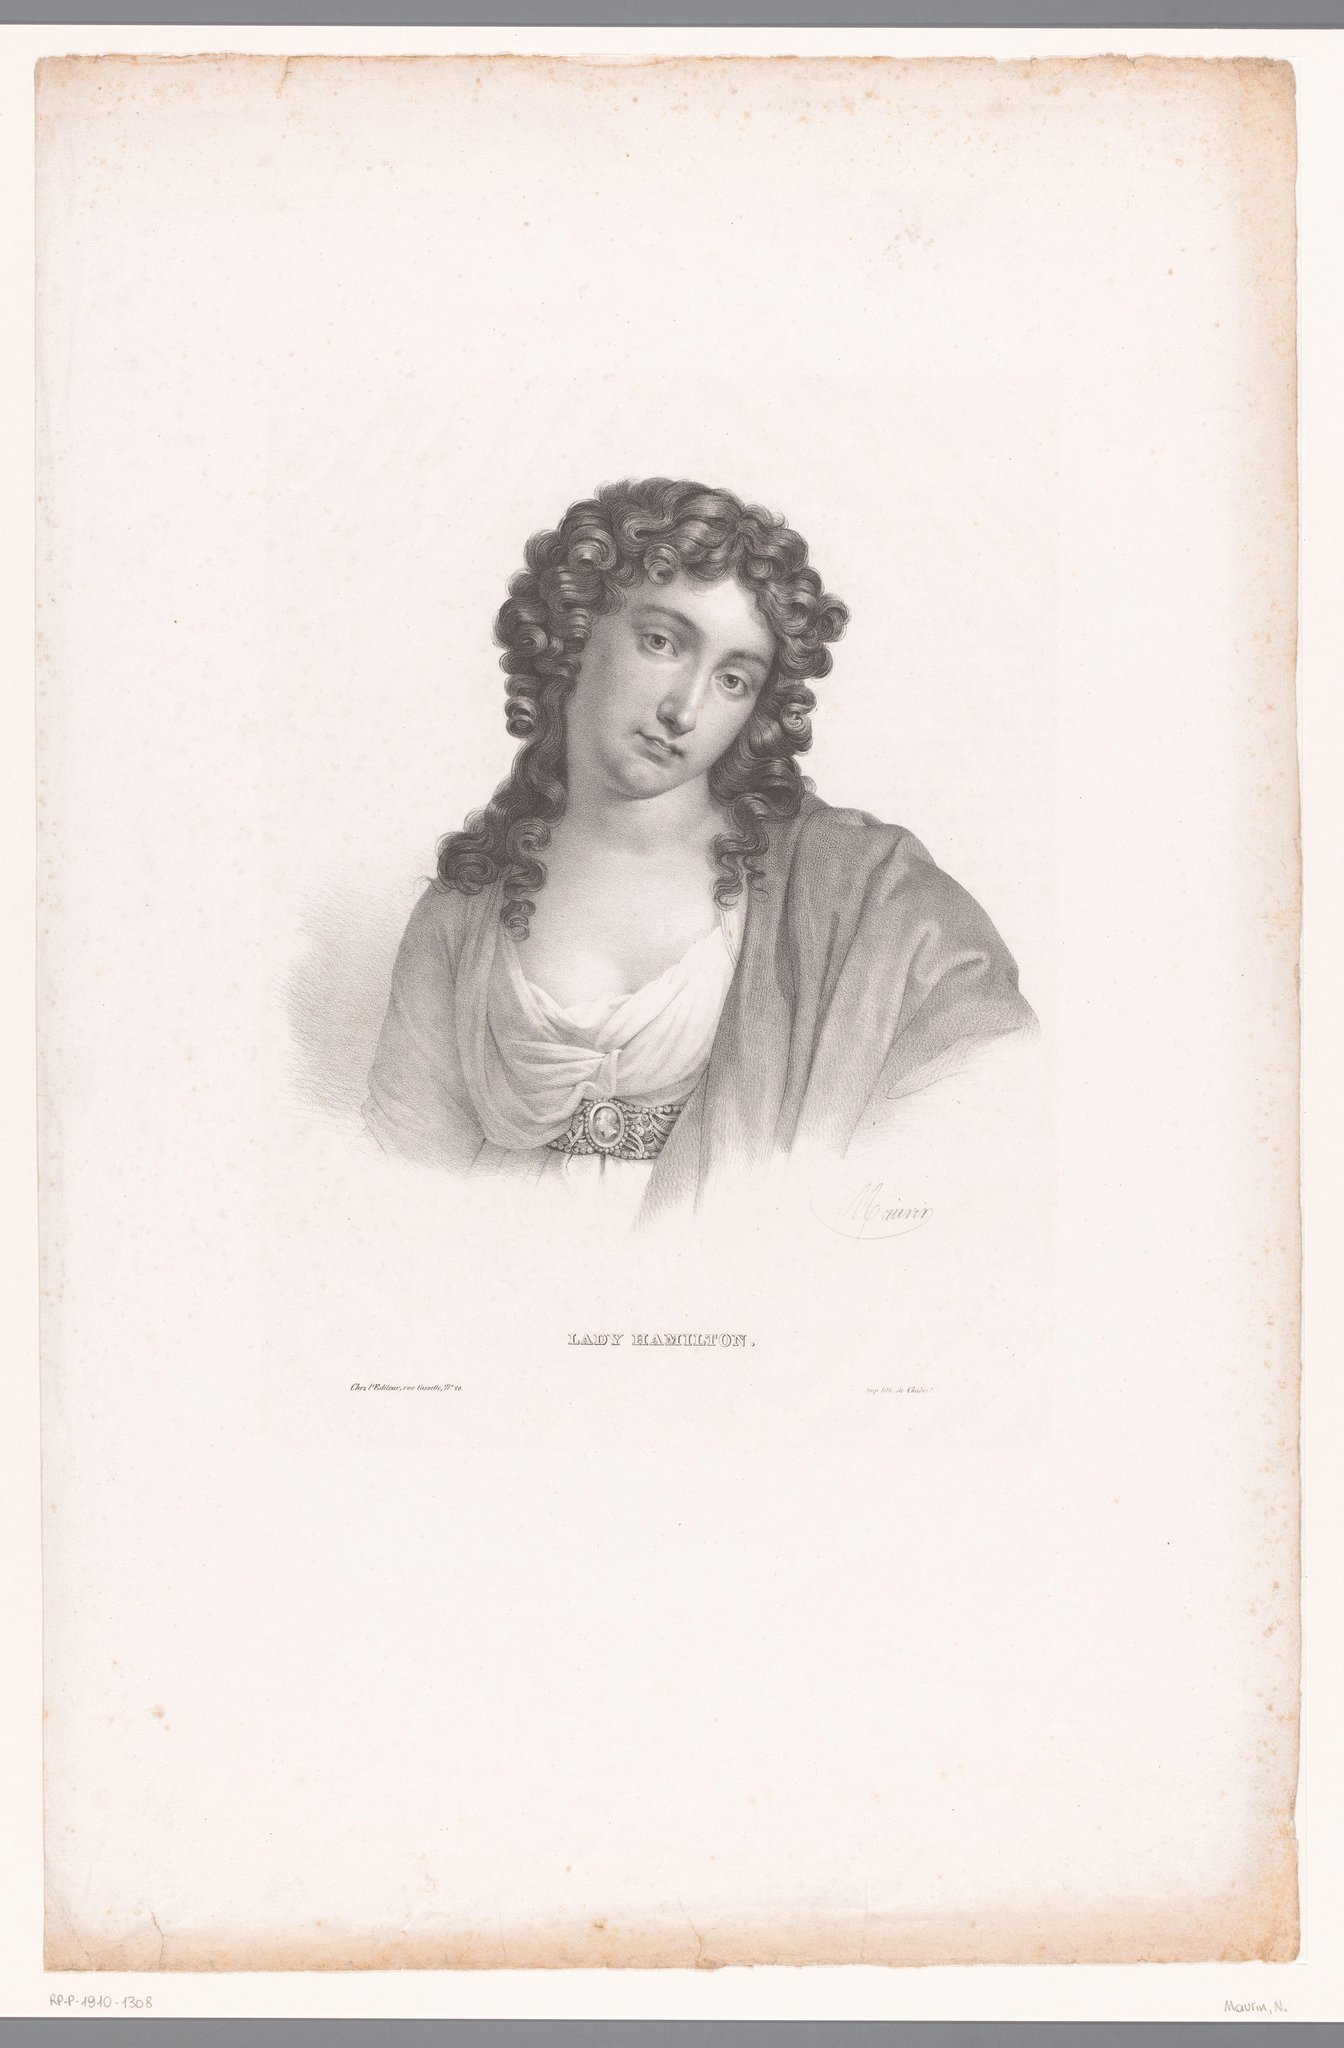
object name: print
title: Lady Hamilton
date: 1827-1854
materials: paper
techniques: lithograph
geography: paris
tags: historical persons, female singer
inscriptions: collector's mark: Lugt 2228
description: Prent waarschijnlijk ook gebruikt in: Chabert, Jean Claude. Galerie des contemporaines, ou collection de portraits des femmes qui se sont rendues célèbres depuis la fin du dix-huitième siècle, en France et dans les pays étrangers. Avec des notices historiques / Galerie des contemporaines ou collection de portraits et biographies des femmes, qui se sont rendues célébres, depuis la fin du dix-huitième siècle, soit en France, soit dans les pays étrangers. Parijs: Jean Claude Chabert en Hennet fils, s.a. [1824-1827]. De samenstelling van tegenwoordig bekende en al dan niet gebonden exemplaren van deze uitgaven verschillen. Dit omdat de prenten en bijhorende stukken tekst op inschrijving en waarschijnlijk ook los verkrijgbaar waren.